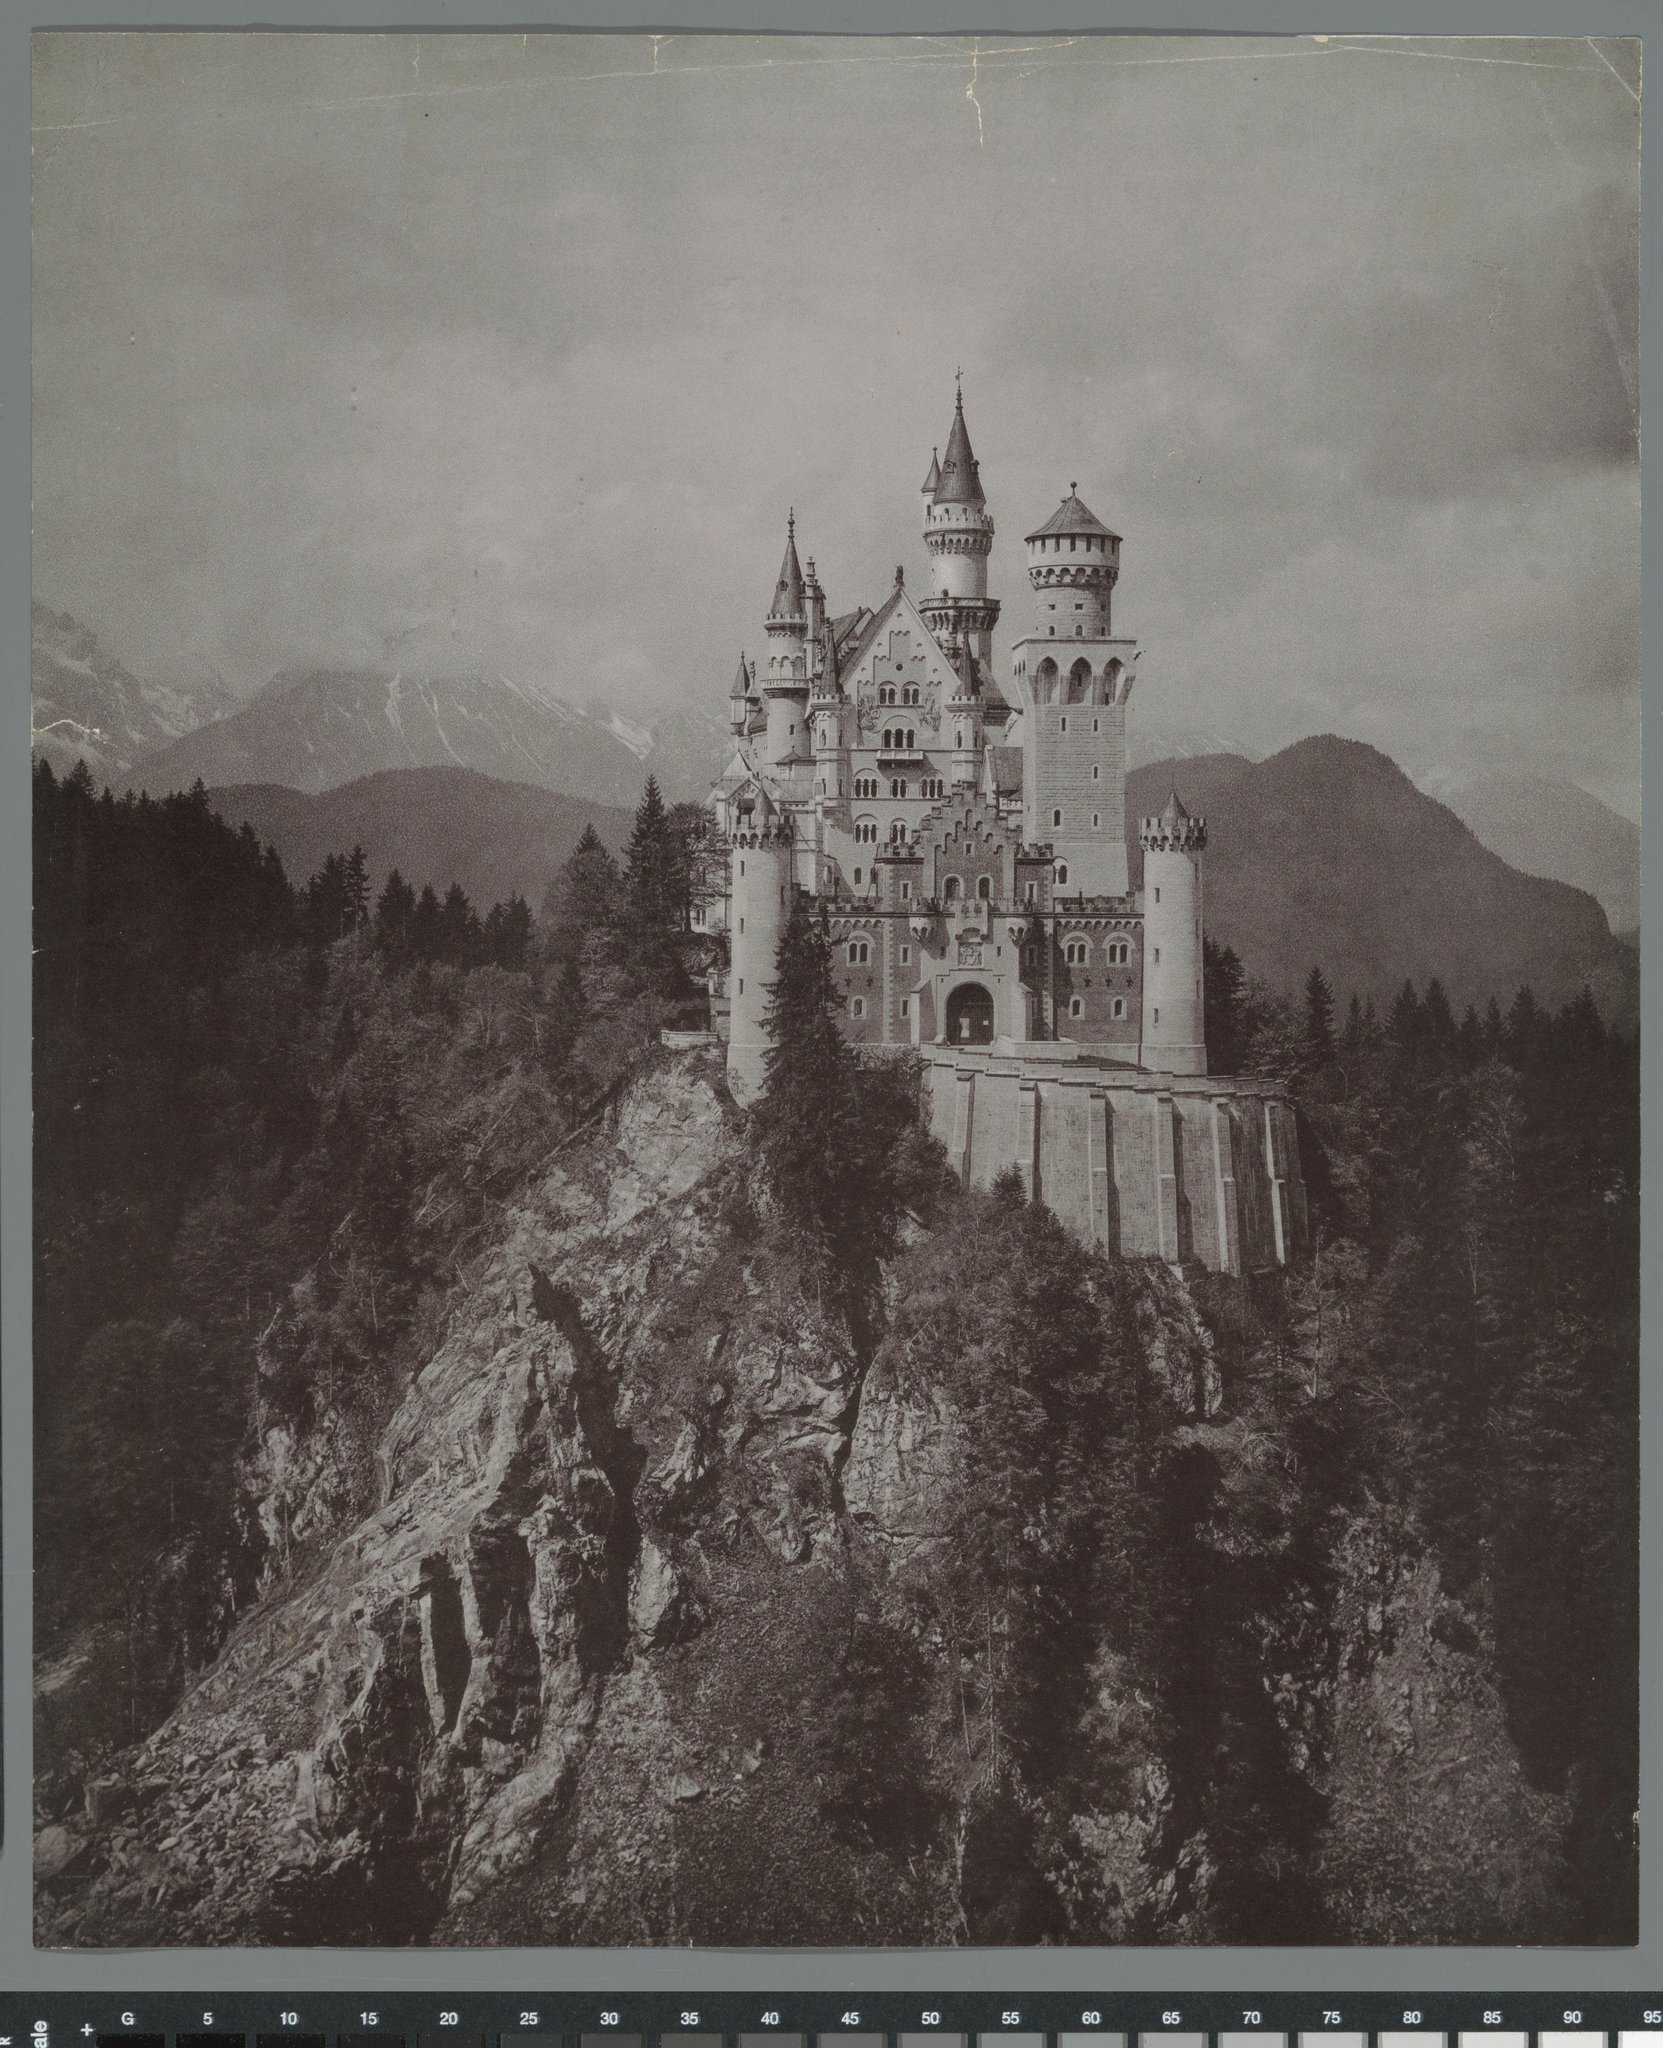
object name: photomechanical print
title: Kasteel Neuschwanstein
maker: Anonymous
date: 1901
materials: paper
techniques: photograph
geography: kaufbeuren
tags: castle, mountains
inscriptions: check stamp: ‘Ver. Kunstanstalten A.G./ Kaufbeuten-München’, date: ‘1901’